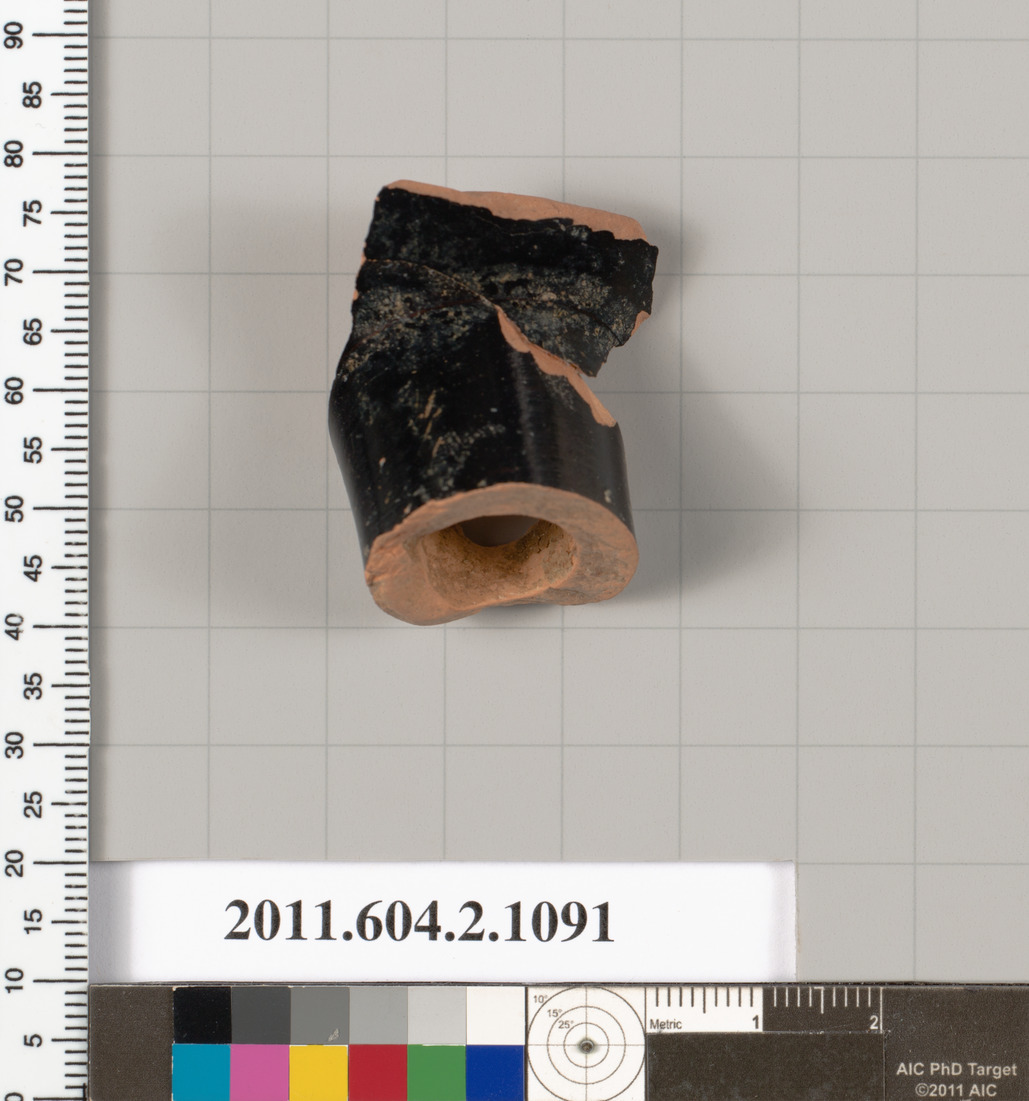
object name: lekythos fragment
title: Terracotta fragment of a lekythos (oil flask)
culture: greek, attic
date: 500-451 BCE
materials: terracotta